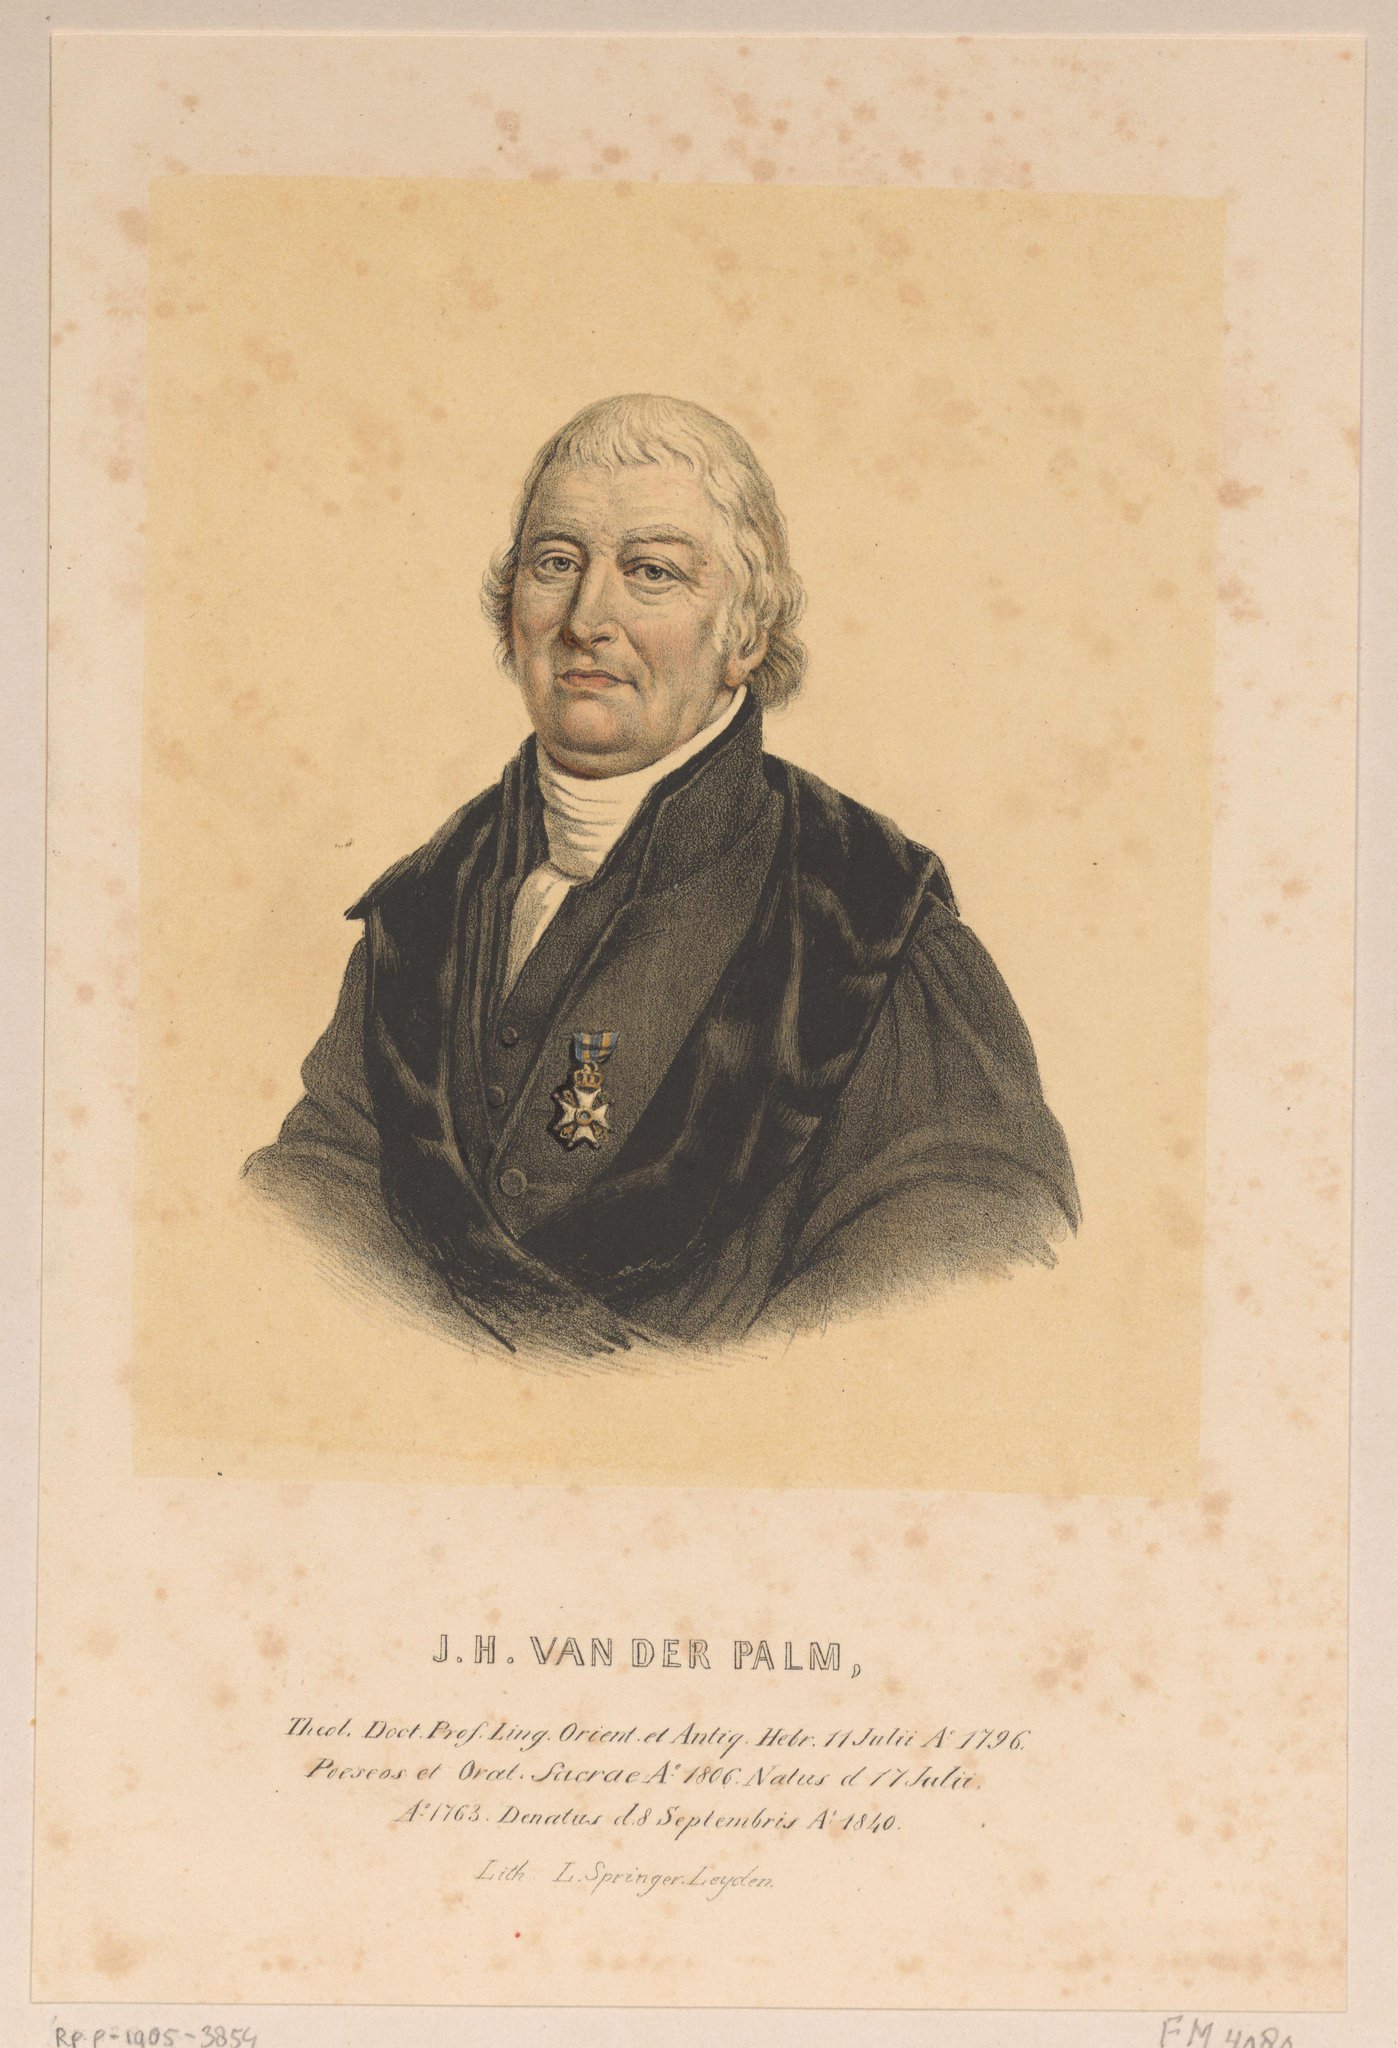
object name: print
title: Portret van Johannes Hendricus van der Palm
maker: leendert springer (i)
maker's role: draughtsman, painter, print maker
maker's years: 1789-1871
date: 1850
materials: paper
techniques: lithograph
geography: leiden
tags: rotterdam, leiden, johannes hendricus van der palm, adult man, historical persons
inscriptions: collector's mark: Lugt 2228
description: Prent uit: Springer, Leendert. Galerij van hoogleeraren aan de Hoogeschool te Leijden, naar de oorspronkelijke afbeeldsels op de Senaat-zaal aldaar berustende. Leiden: Leendert Springer, [1850].